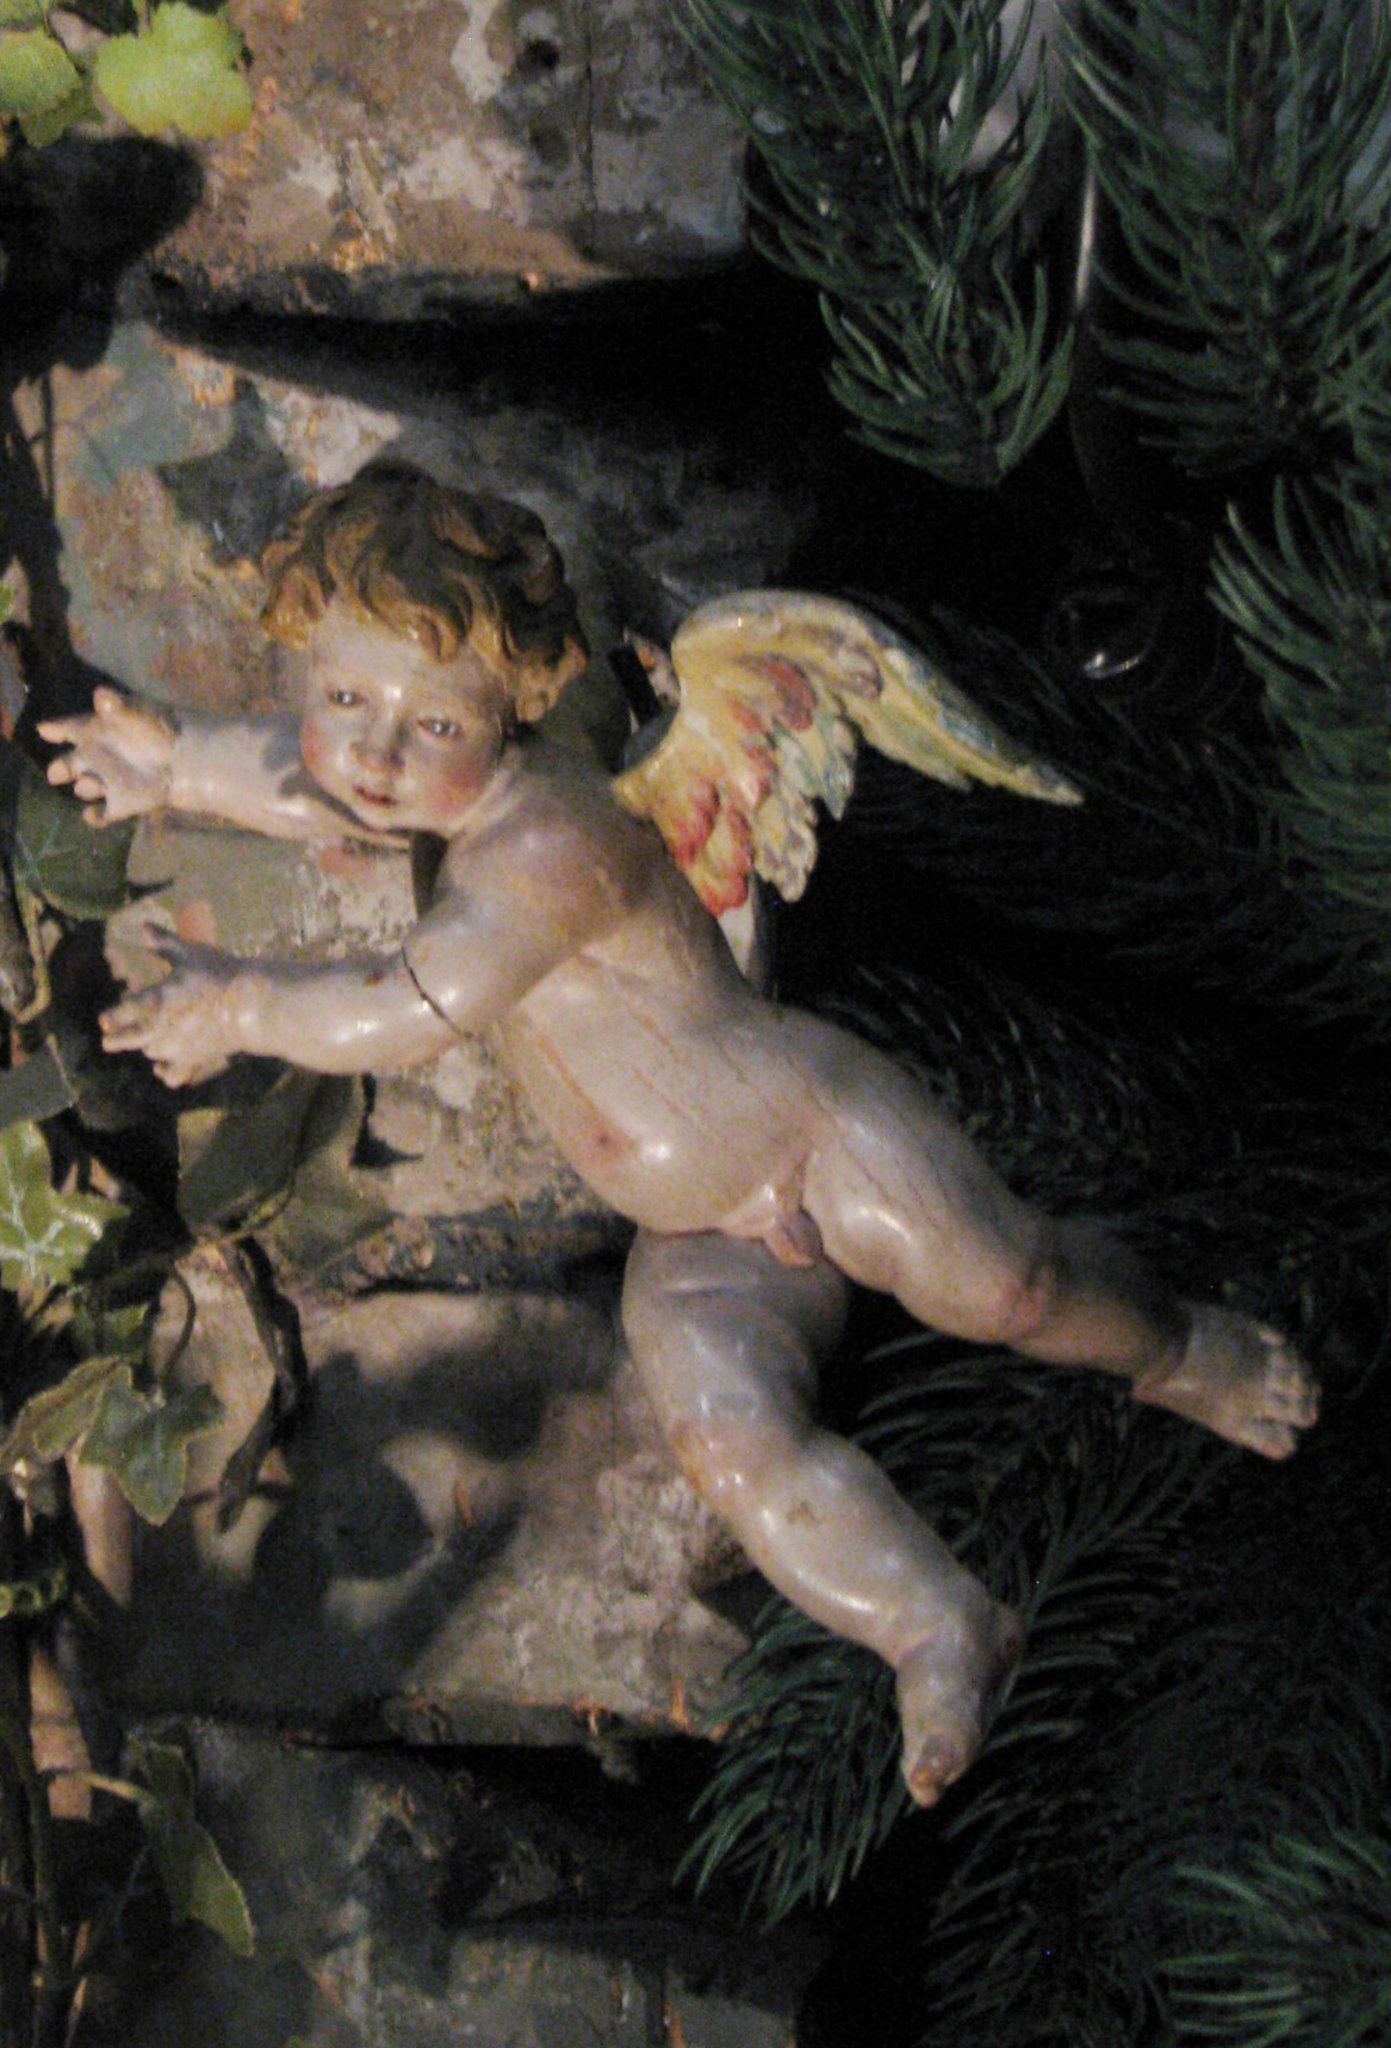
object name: crèche figure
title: Cherub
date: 1751-1800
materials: wood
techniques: polychrome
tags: angels